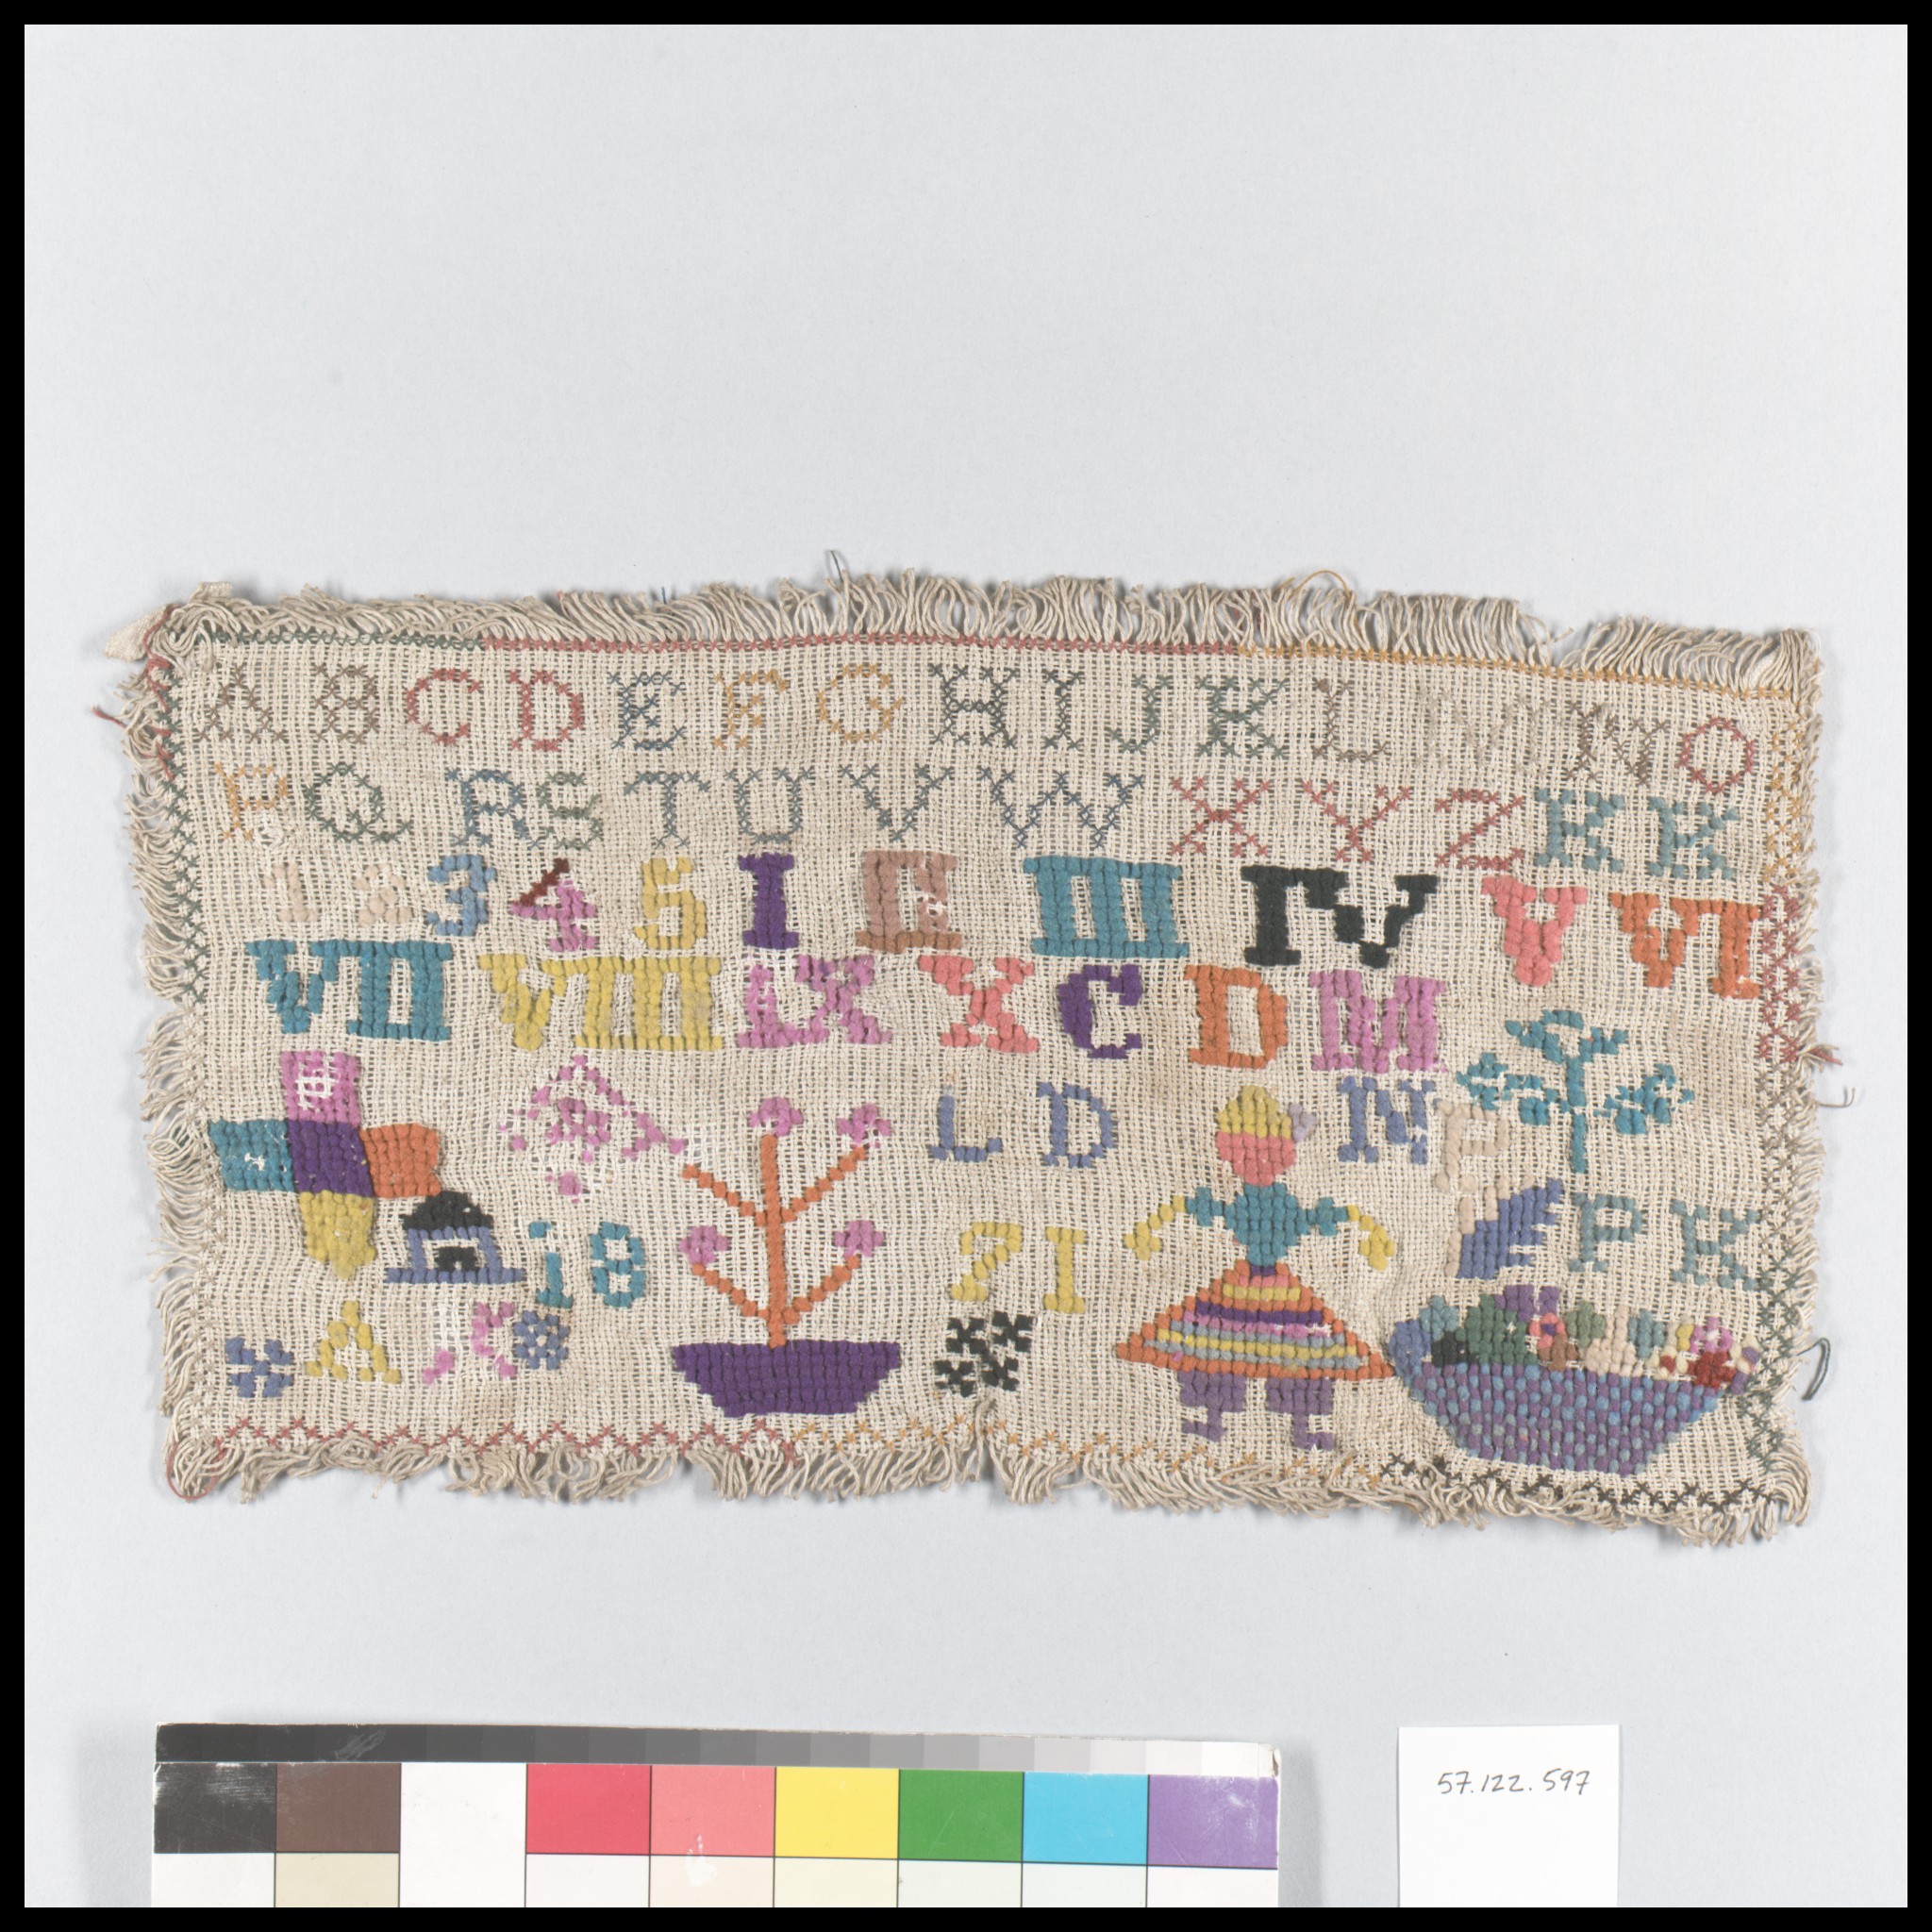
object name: sampler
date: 1871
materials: canvas, cotton, wool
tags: human figures